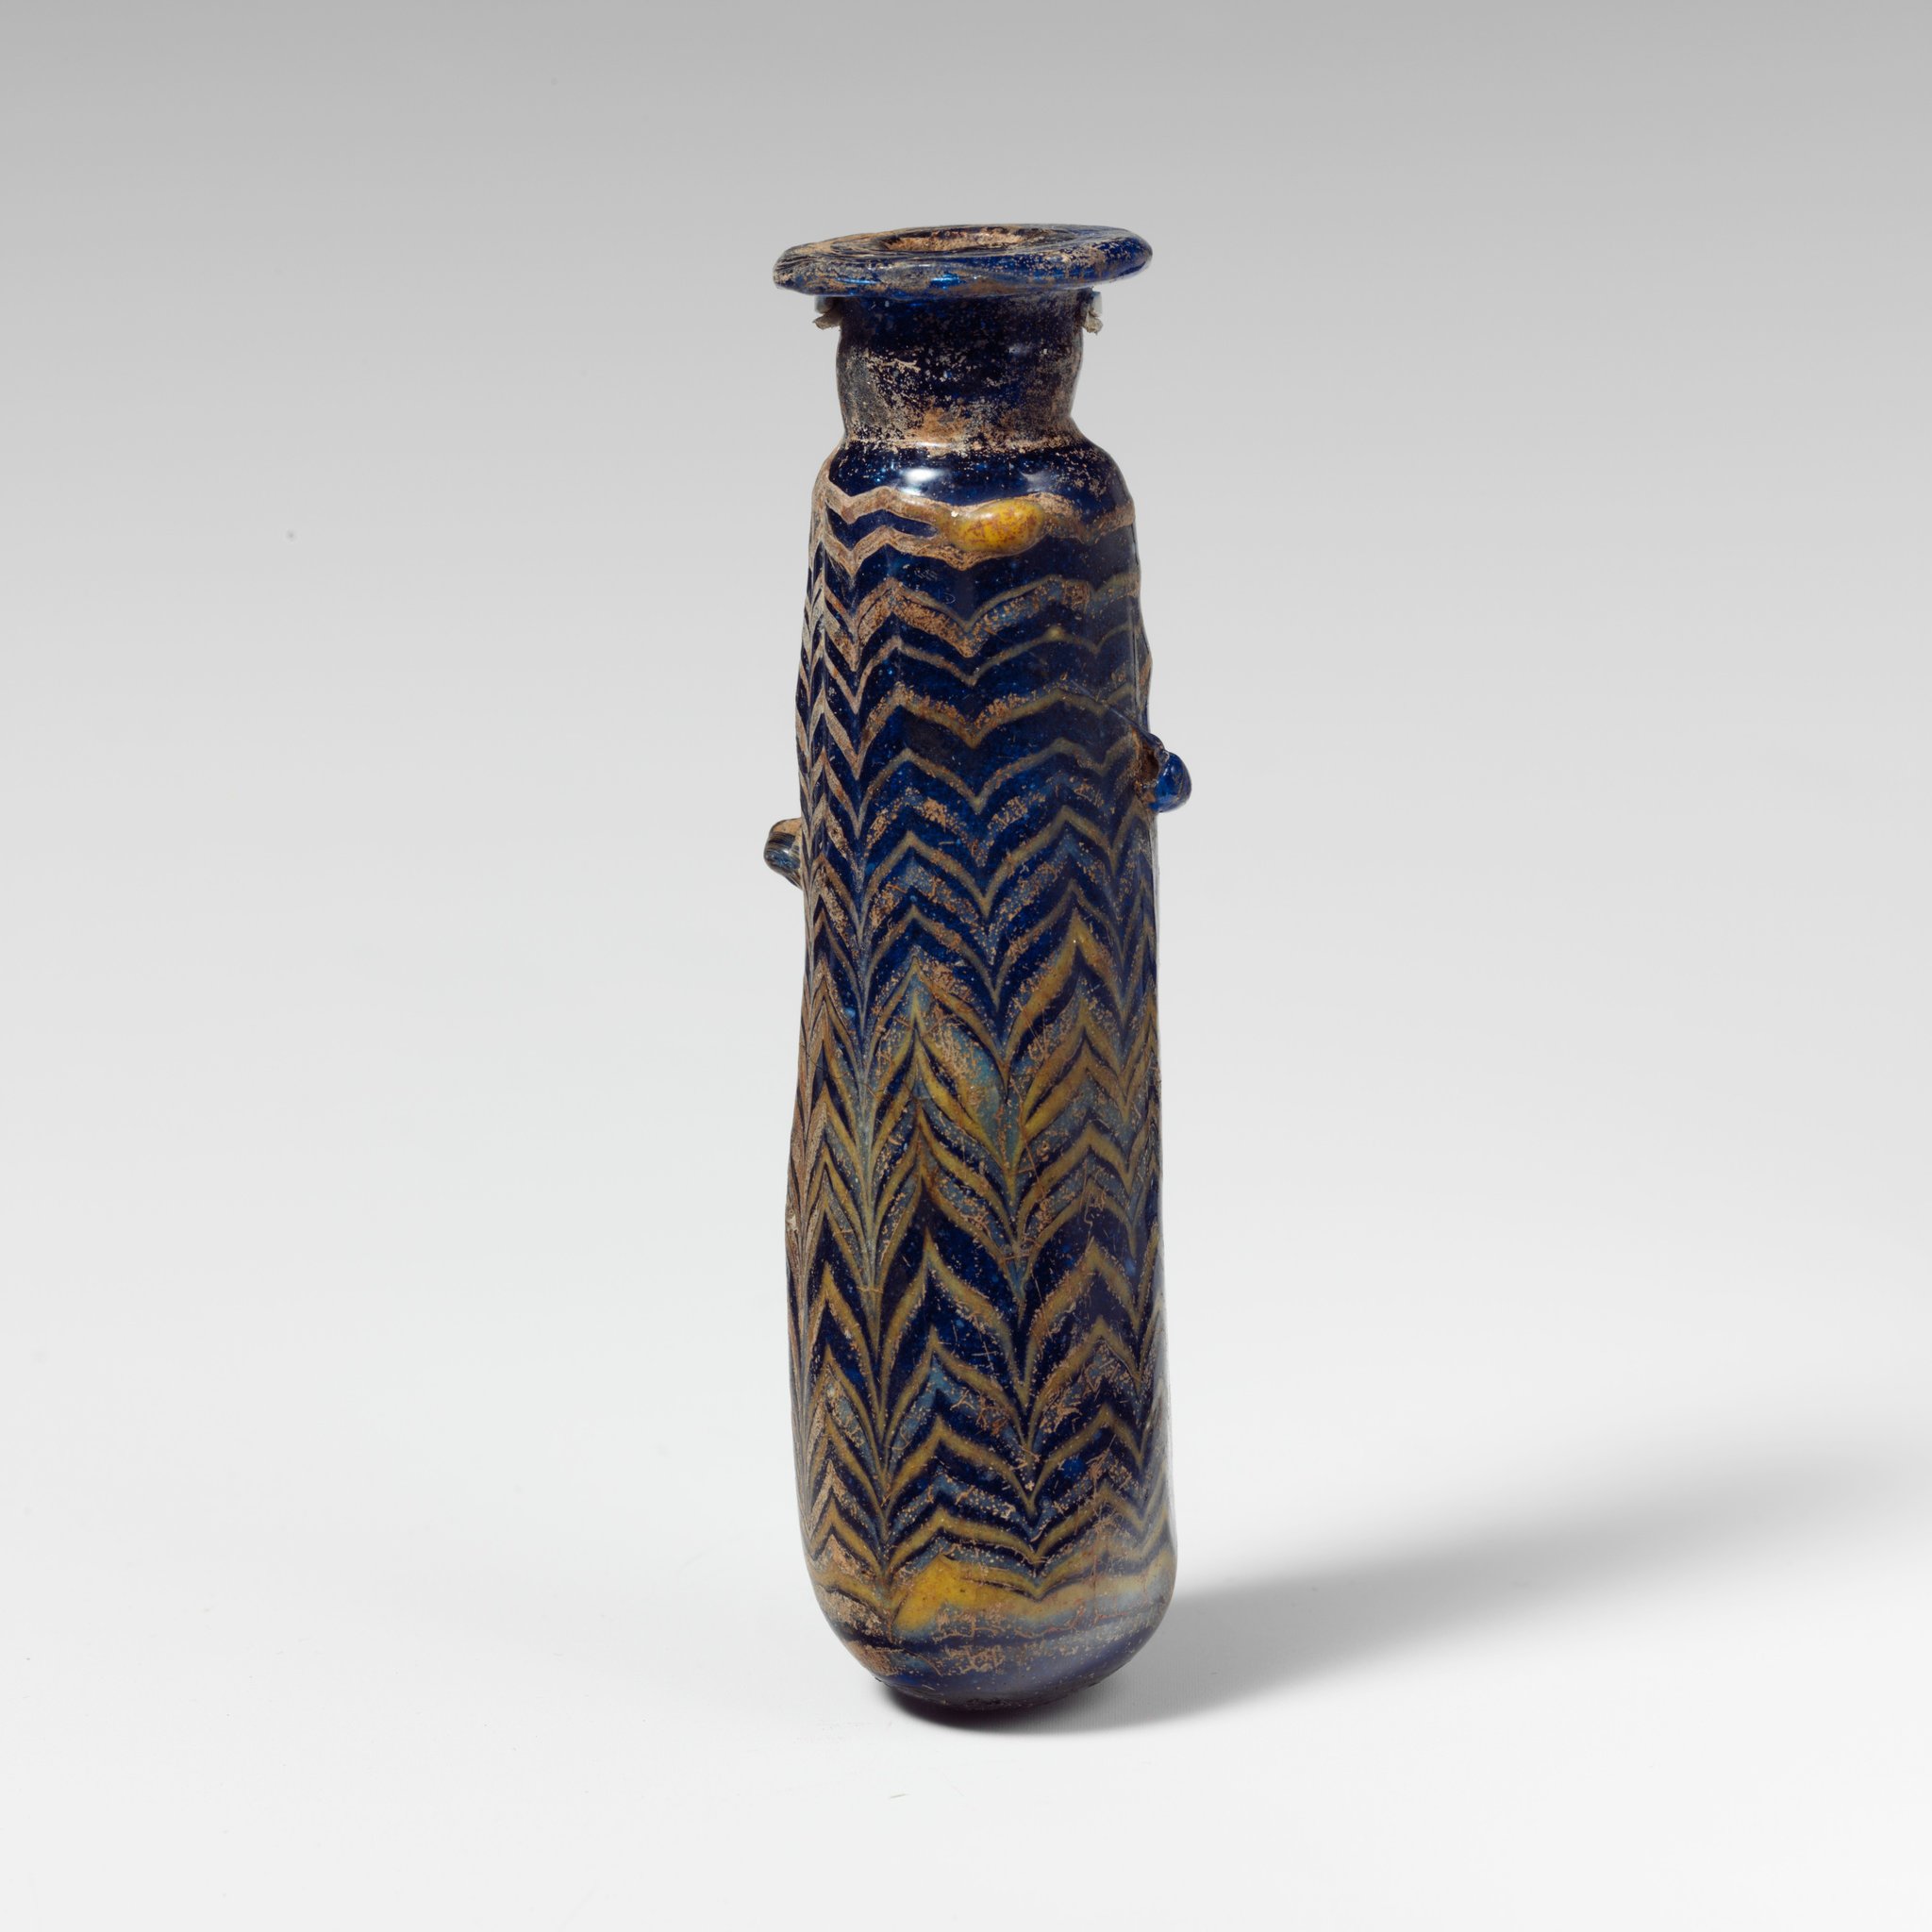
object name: alabastron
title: Glass alabastron (perfume bottle)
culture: greek or eastern mediterranean or italian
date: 367-268 BCE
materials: glass